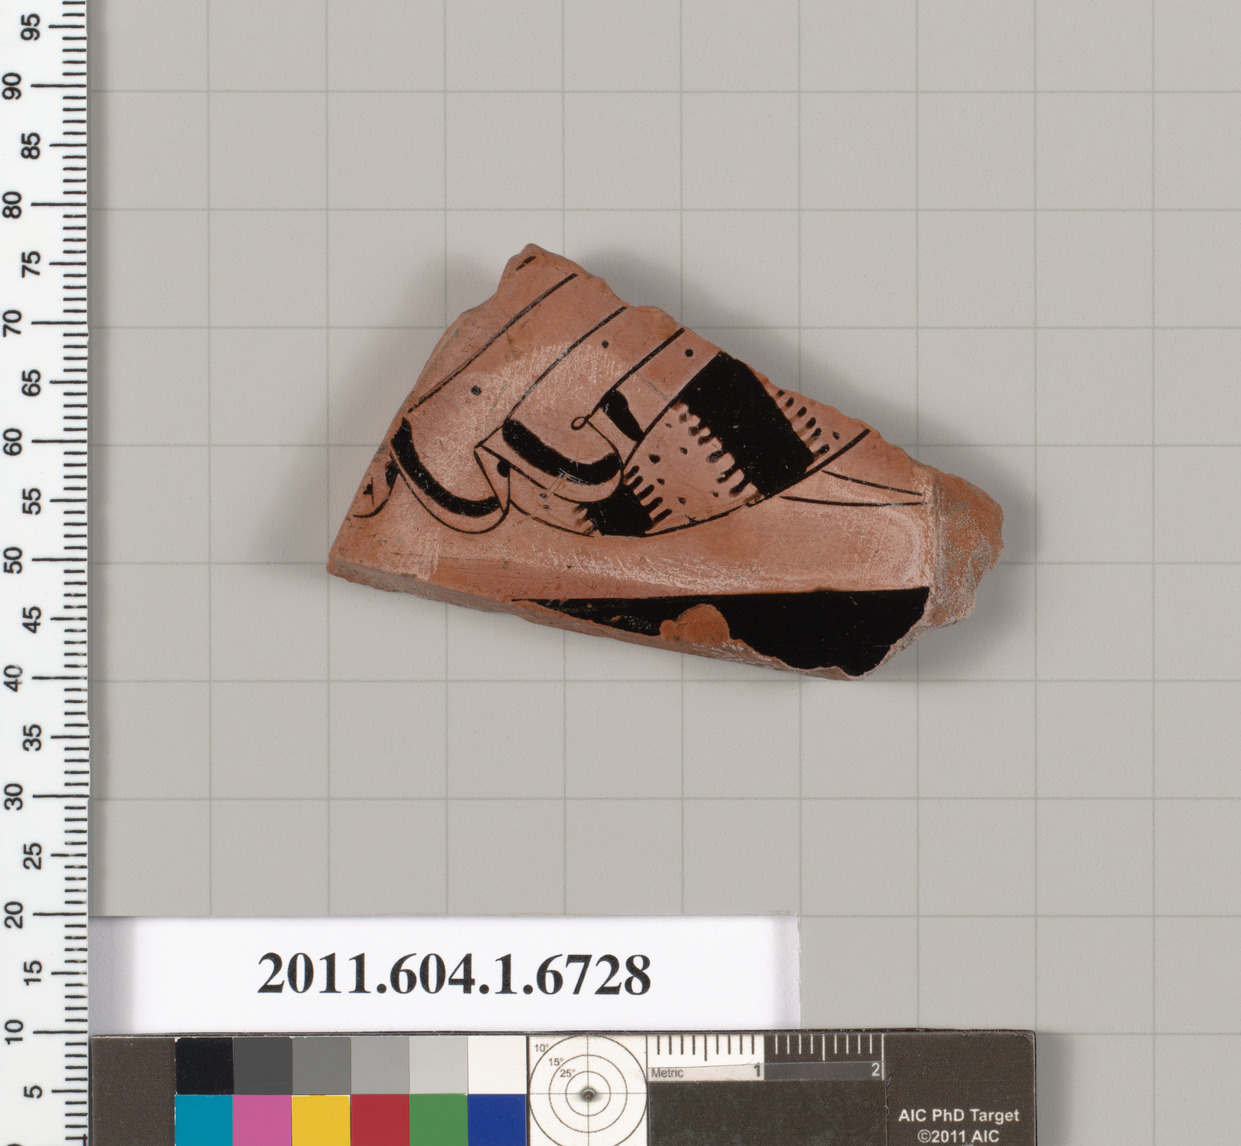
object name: kylix fragment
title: Terracotta fragment of a kylix (drinking cup)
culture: greek, attic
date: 490-470 BCE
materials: terracotta